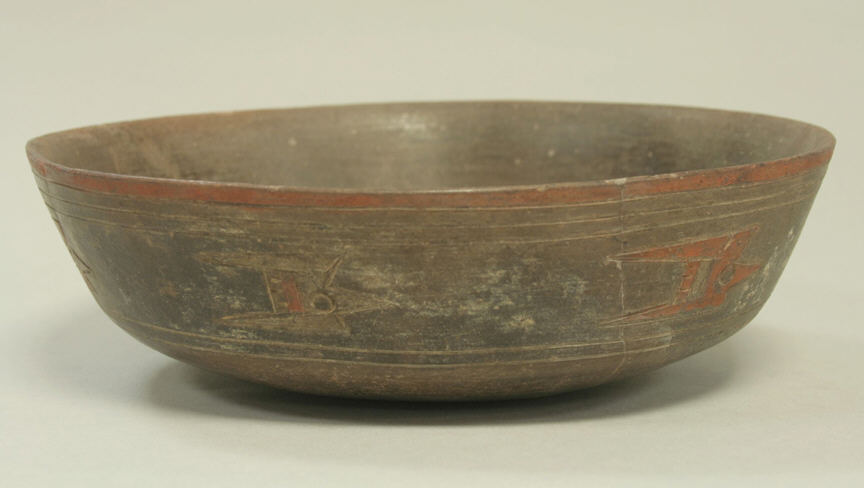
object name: bowl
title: Incised bowl with birds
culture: paracas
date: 300-101 BCE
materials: ceramic, pigment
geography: peru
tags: birds